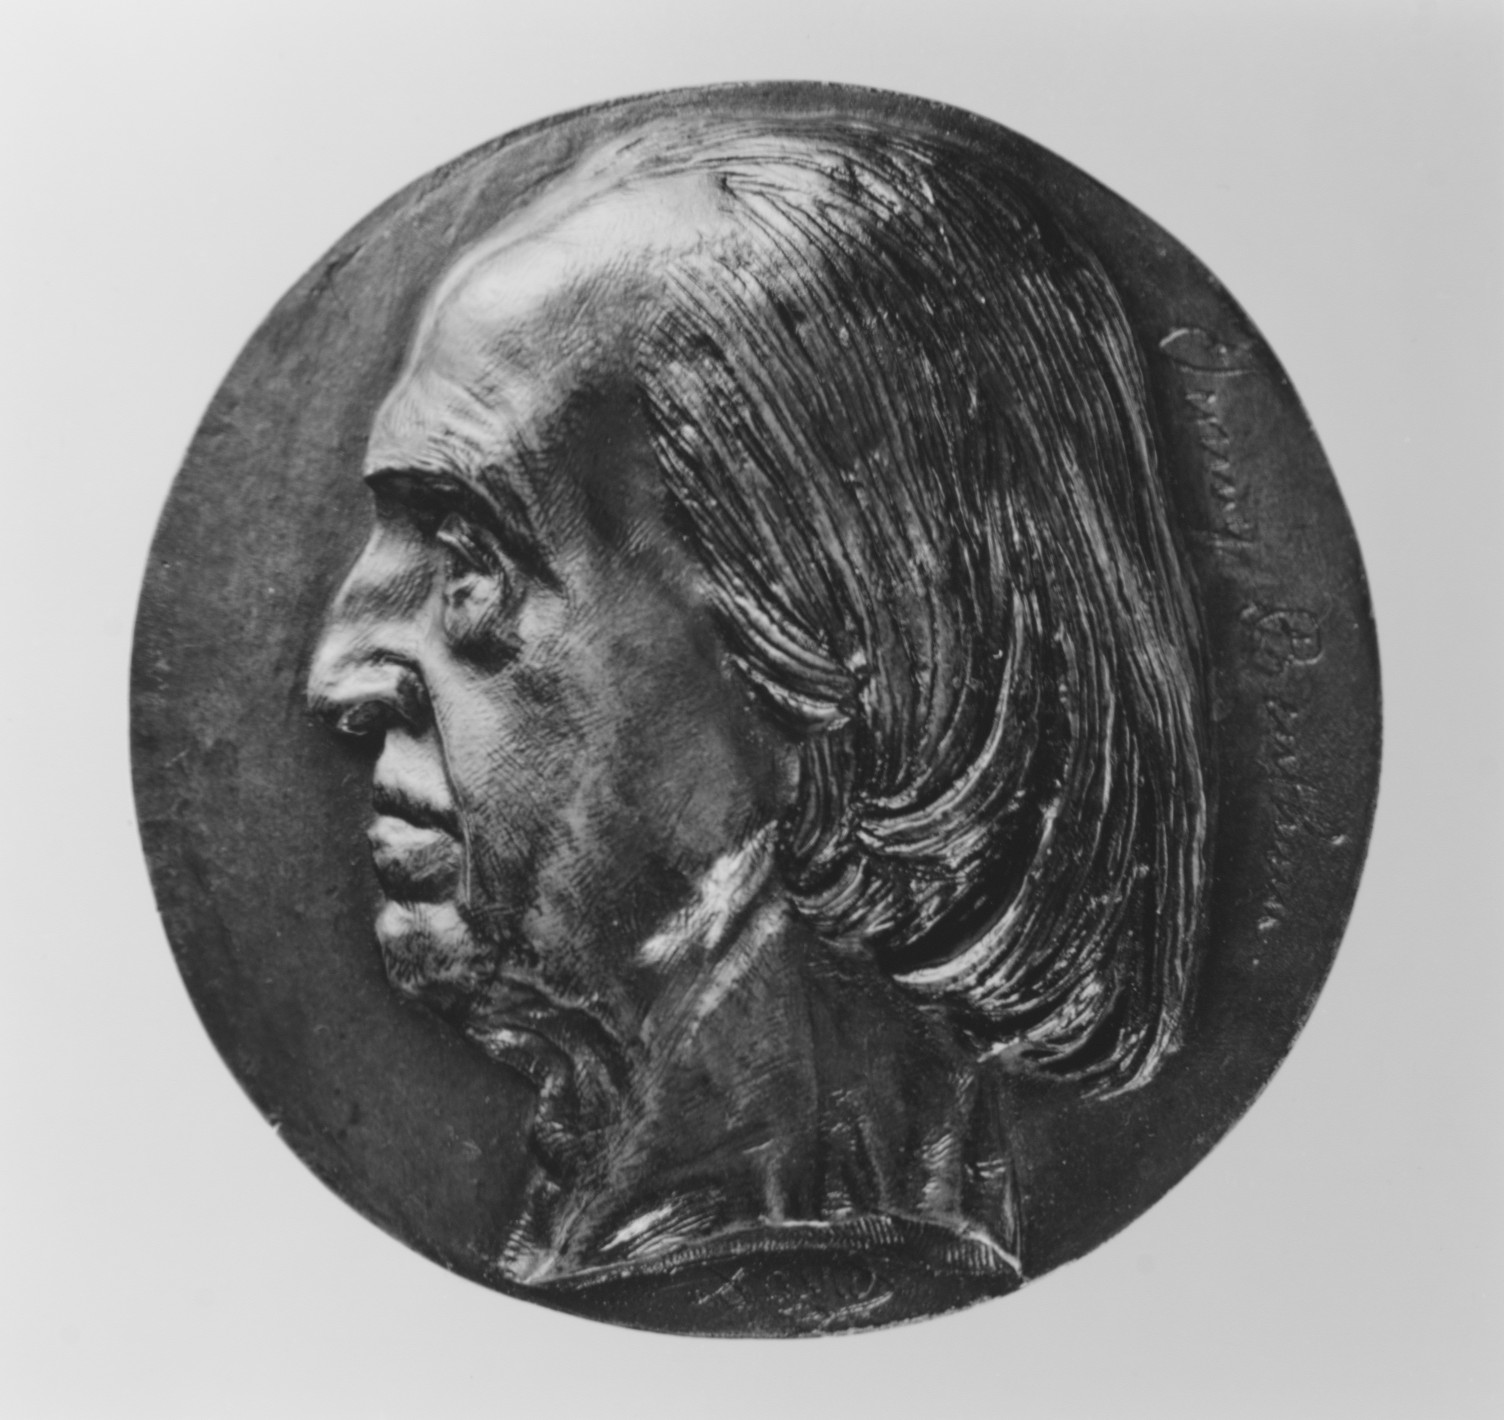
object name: medallion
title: Jeremy Bentham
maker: pierre jean david d'angers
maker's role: artist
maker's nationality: french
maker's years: 1788-1856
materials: bronze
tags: men,profiles